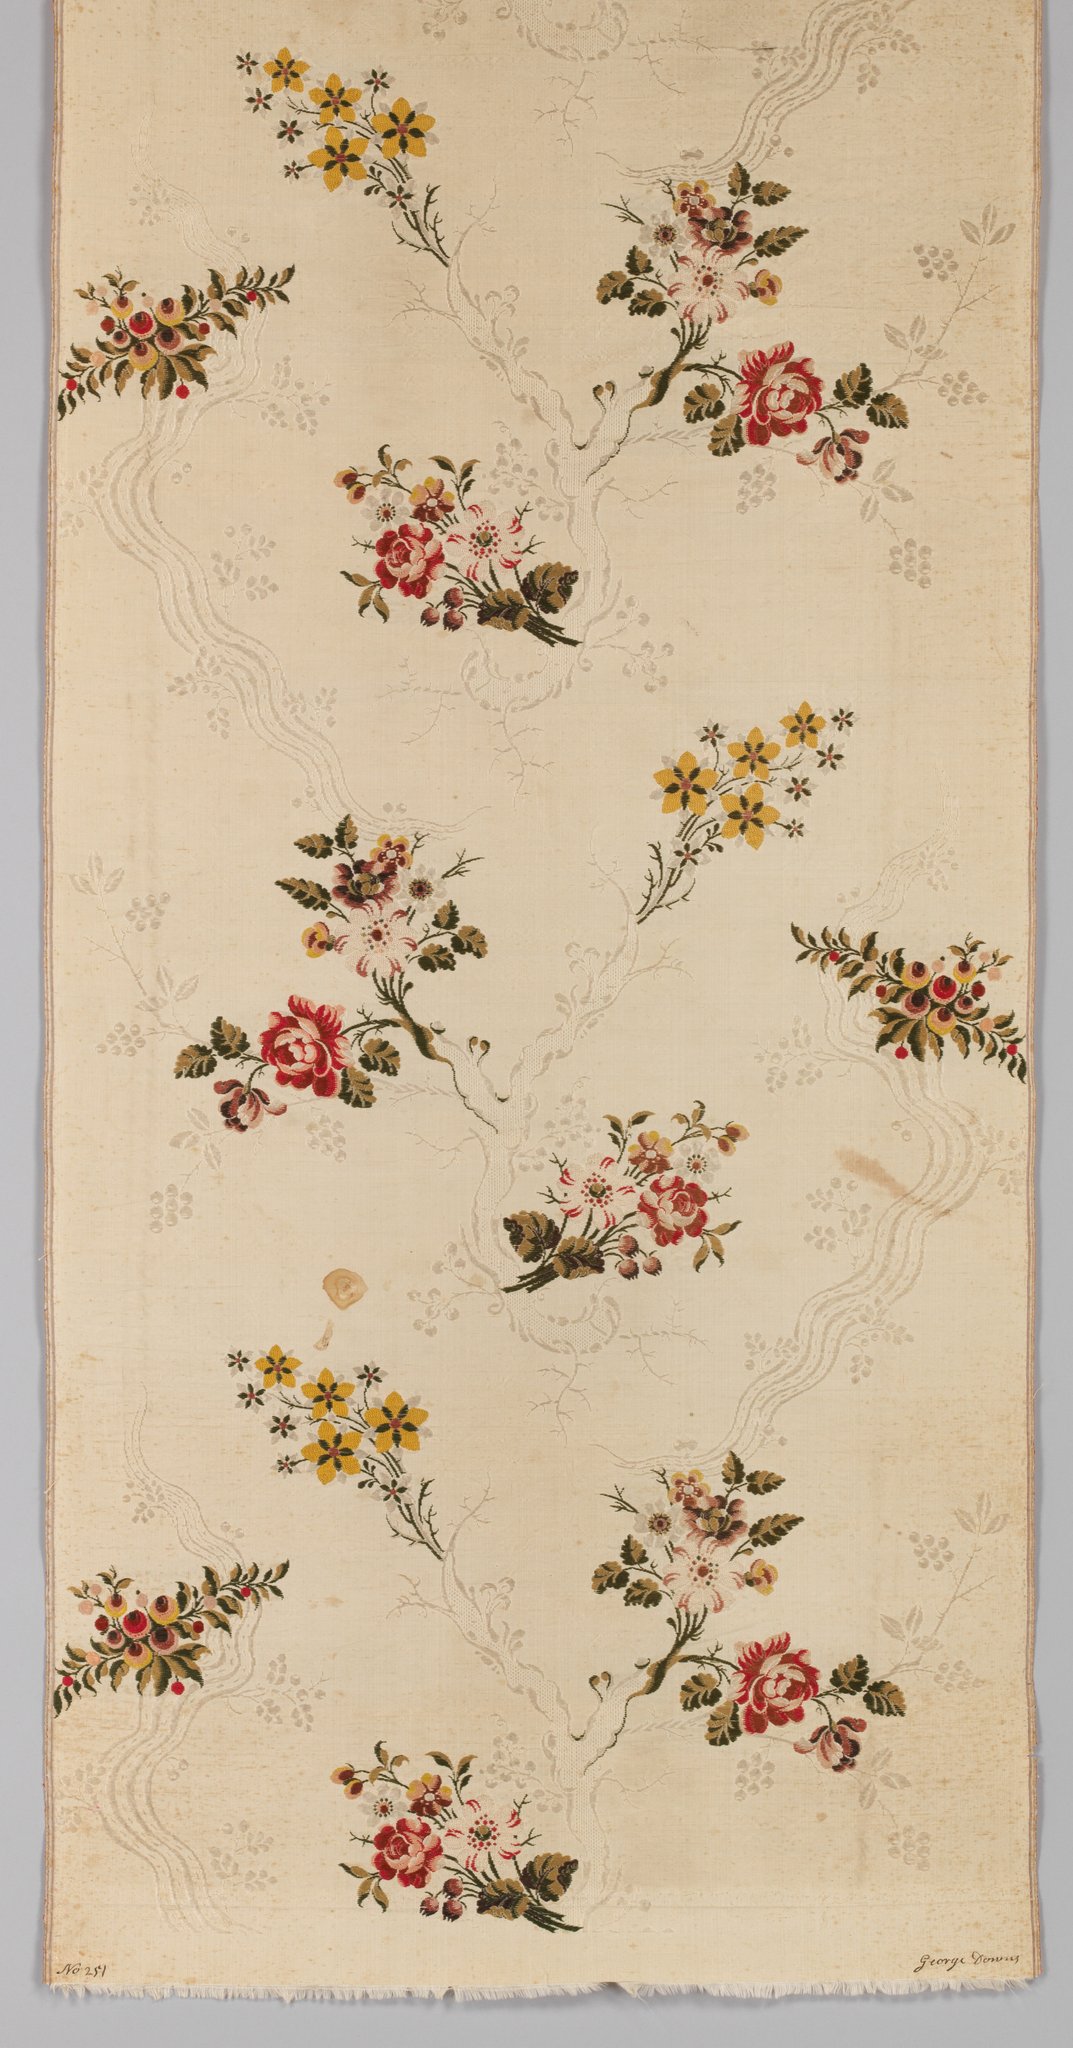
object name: piece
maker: george downs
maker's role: designer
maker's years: 1700-1800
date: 1760-1765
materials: silk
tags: flowers,leaves